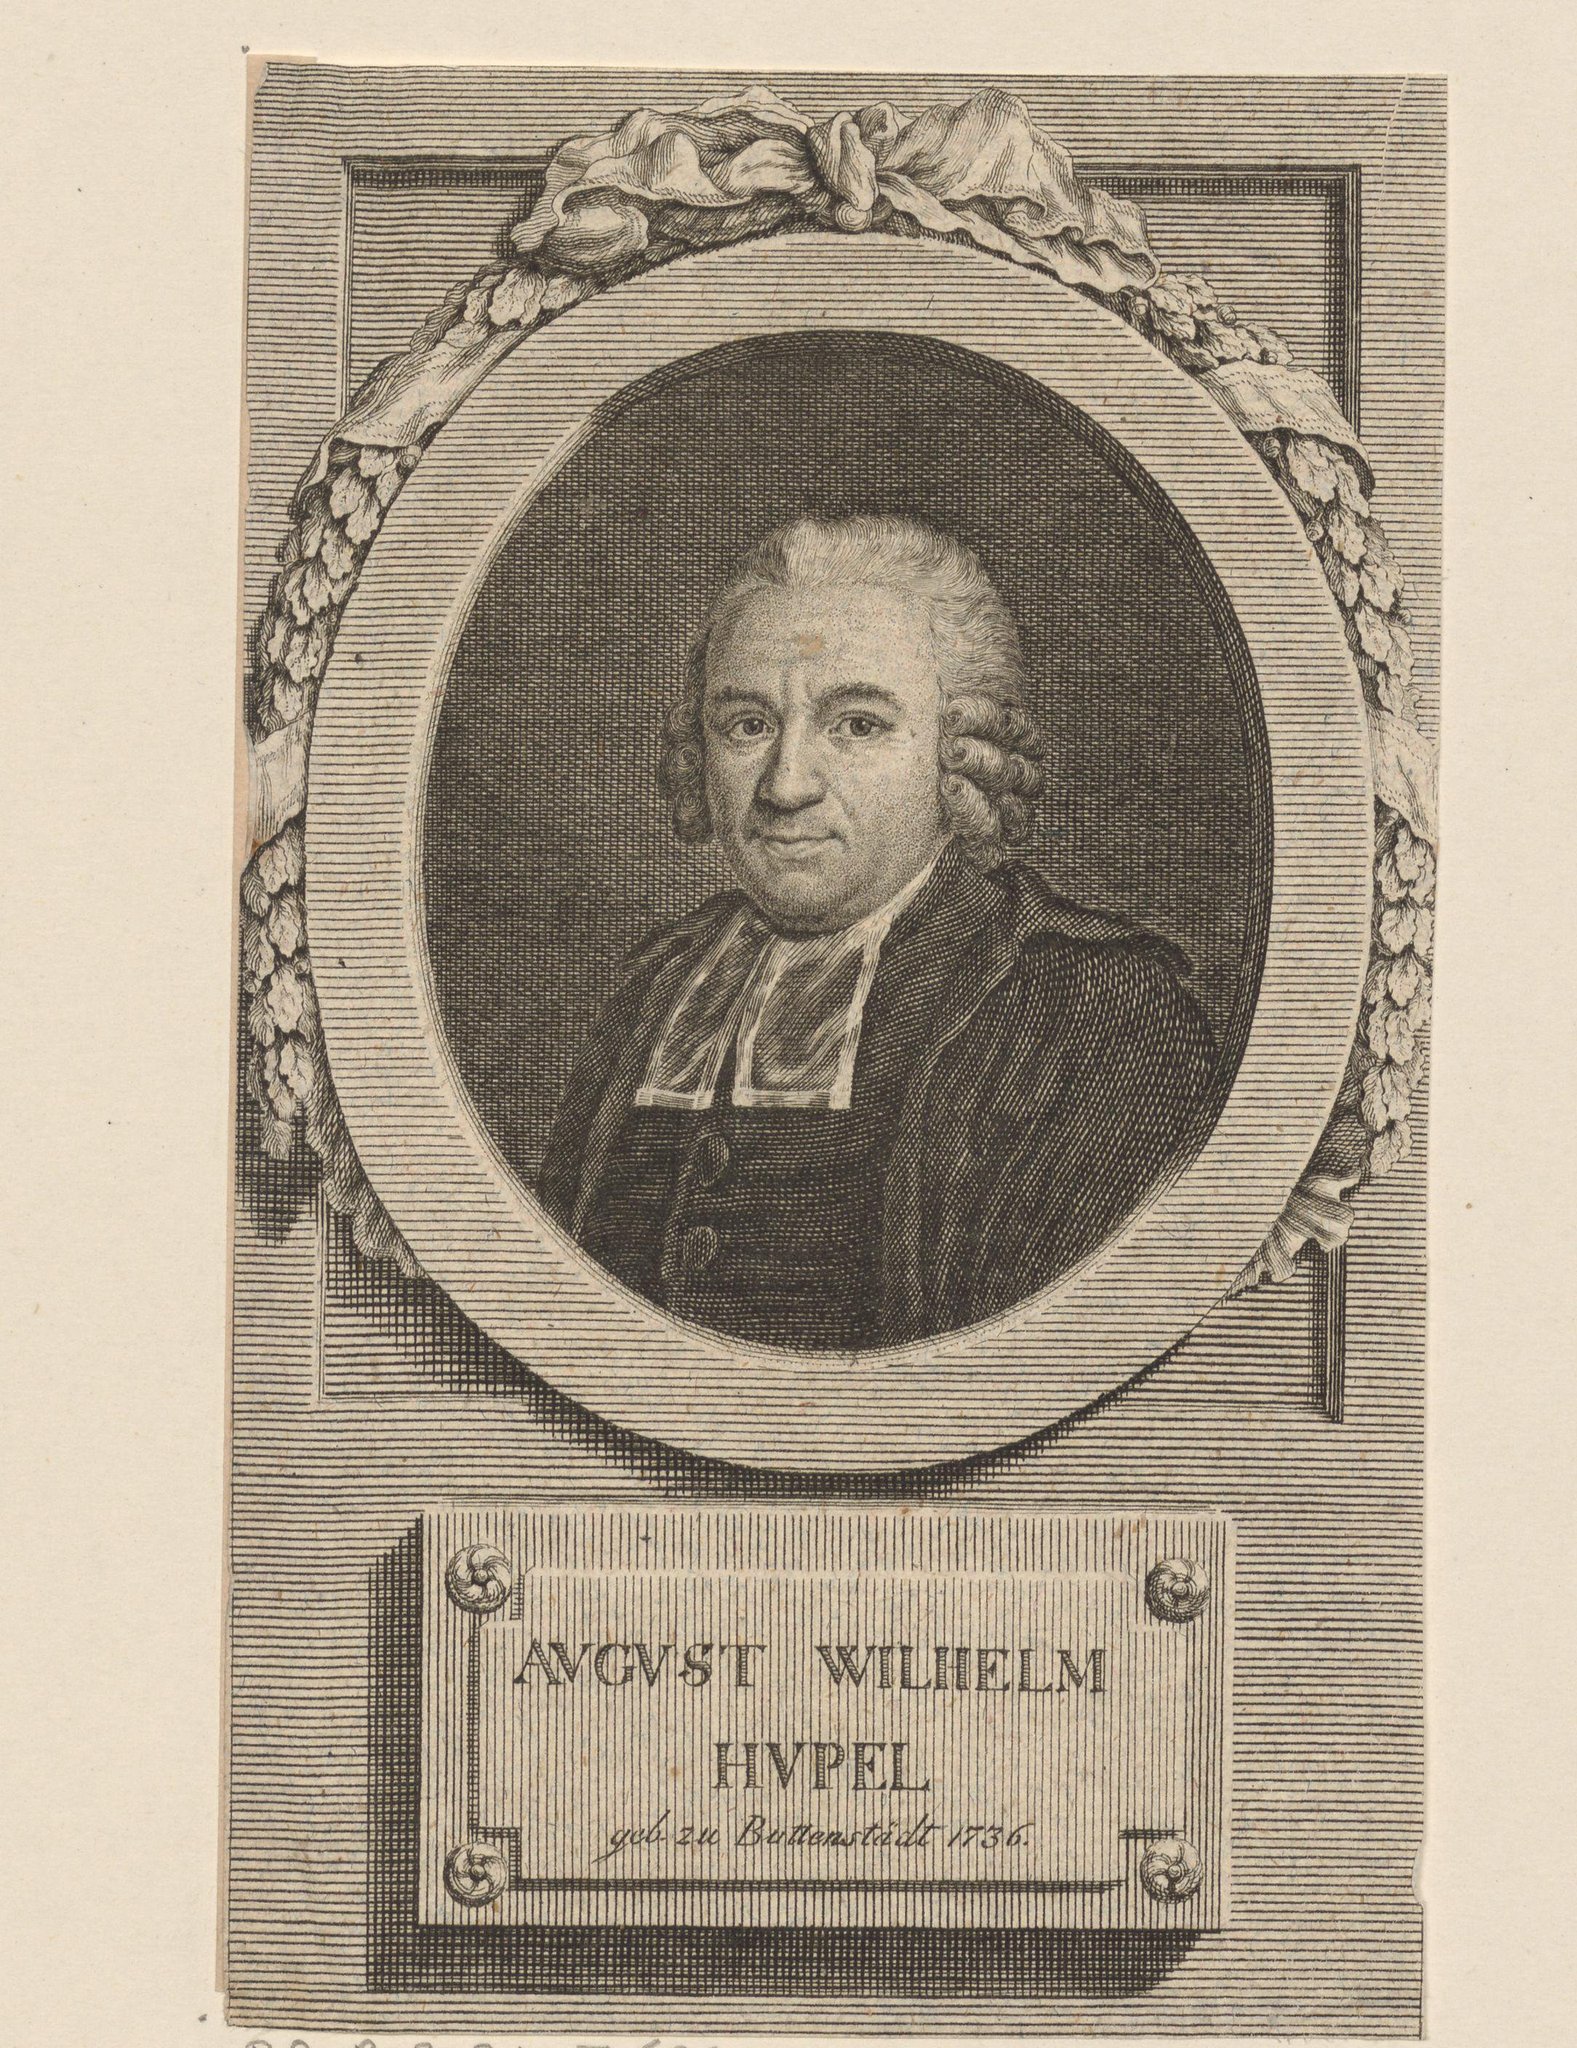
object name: print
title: Portret van August Wilhelm Hupel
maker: eberhard siegfried henne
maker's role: print maker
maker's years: 1759-1828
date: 1775-1799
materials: paper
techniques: engraving, etching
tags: theologian, historical persons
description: Prent gebruikt in: Allgemeine deutsche Bibliothek. Berlijn en Stettin: Friedrich Nicolai, 1791, dl. 104.1.